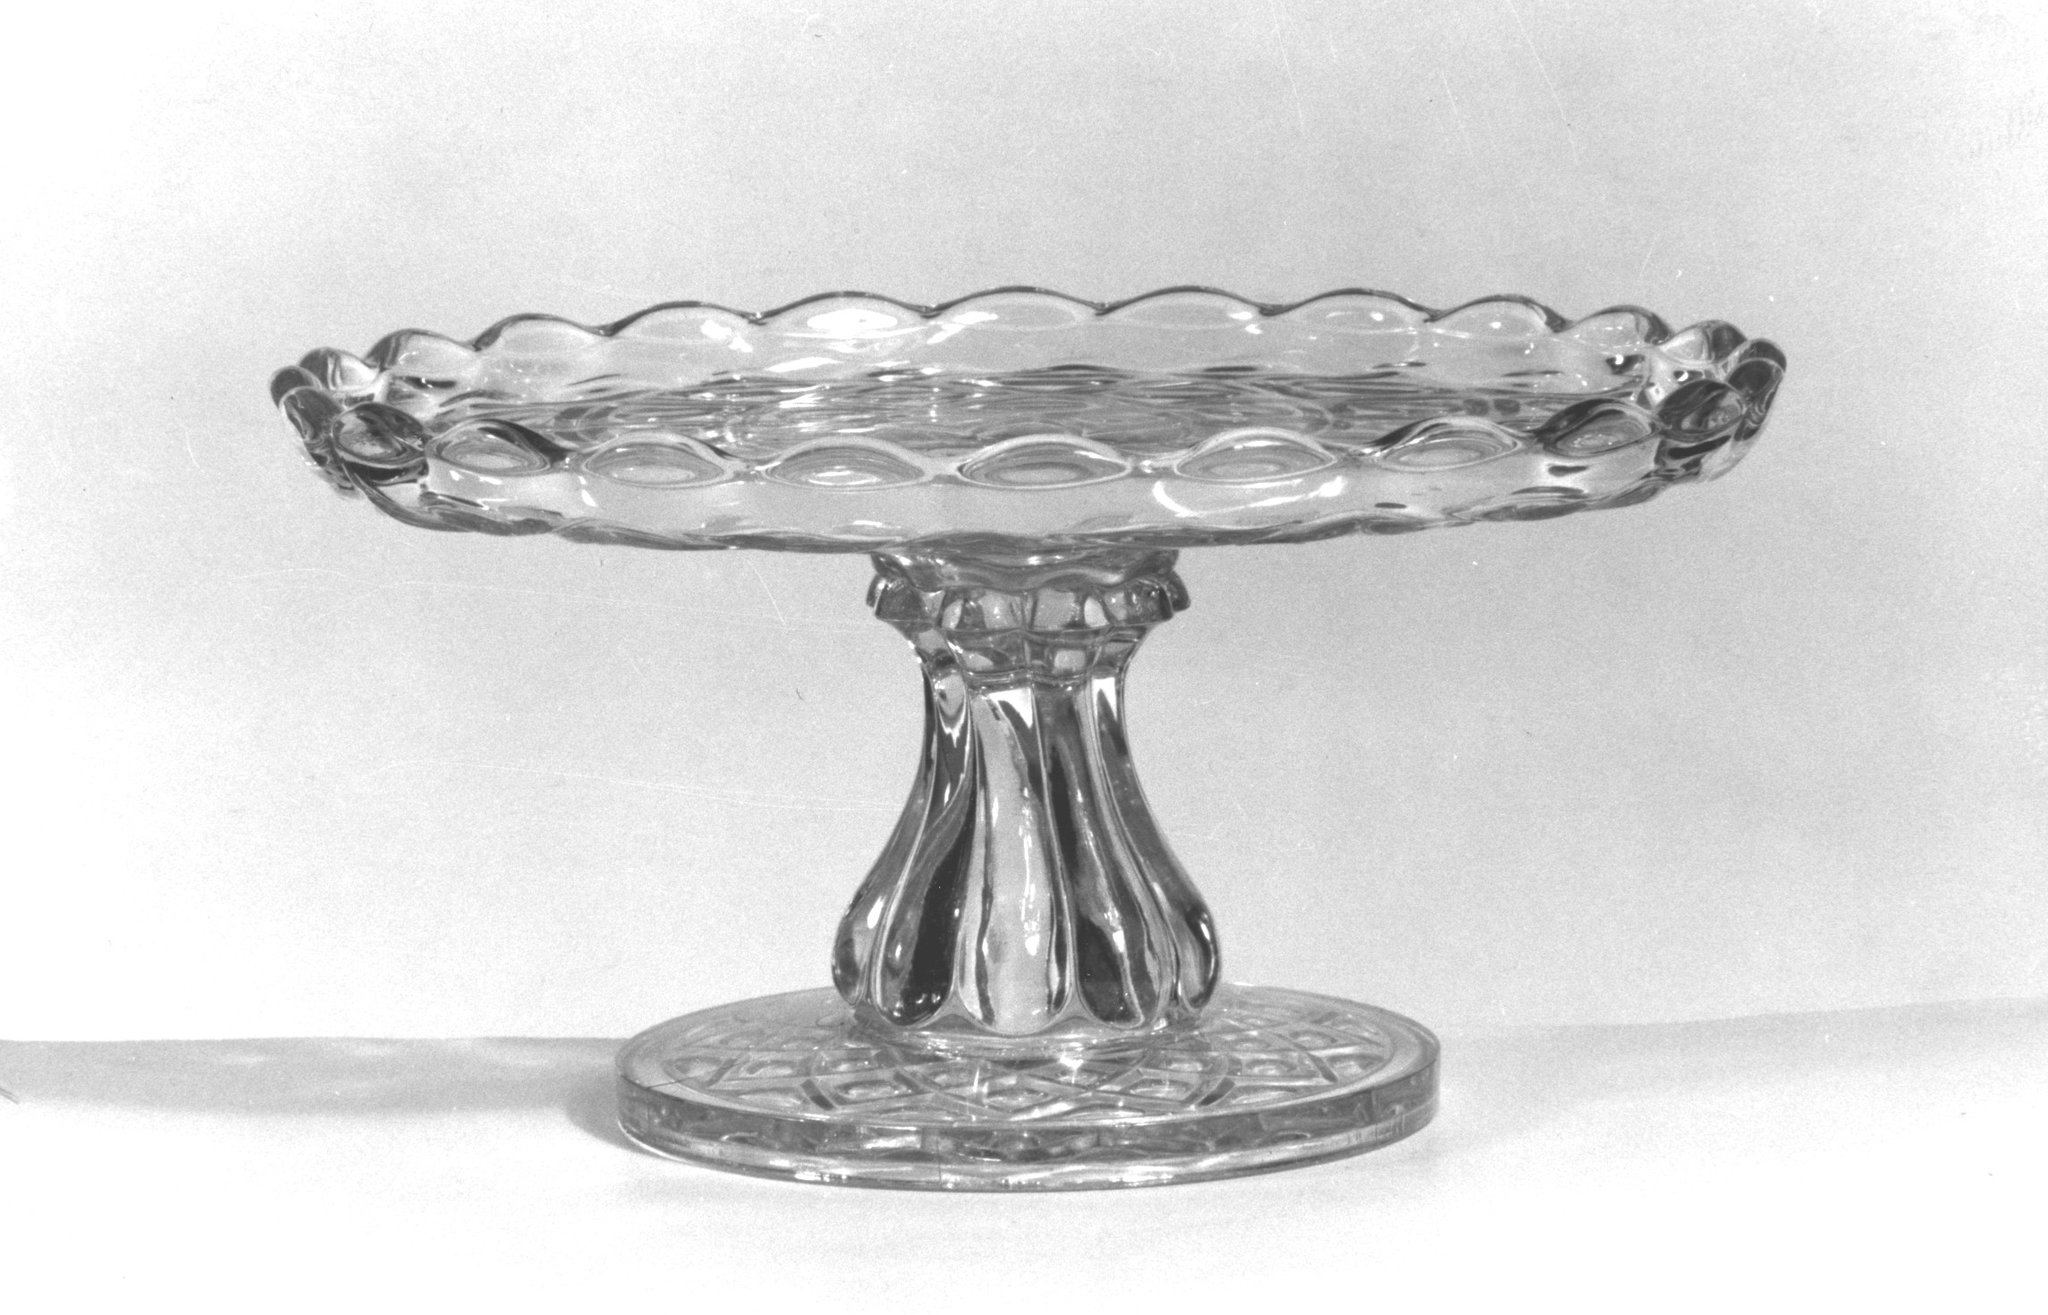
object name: cake plate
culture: american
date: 1850-1870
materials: glass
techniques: pressed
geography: united states